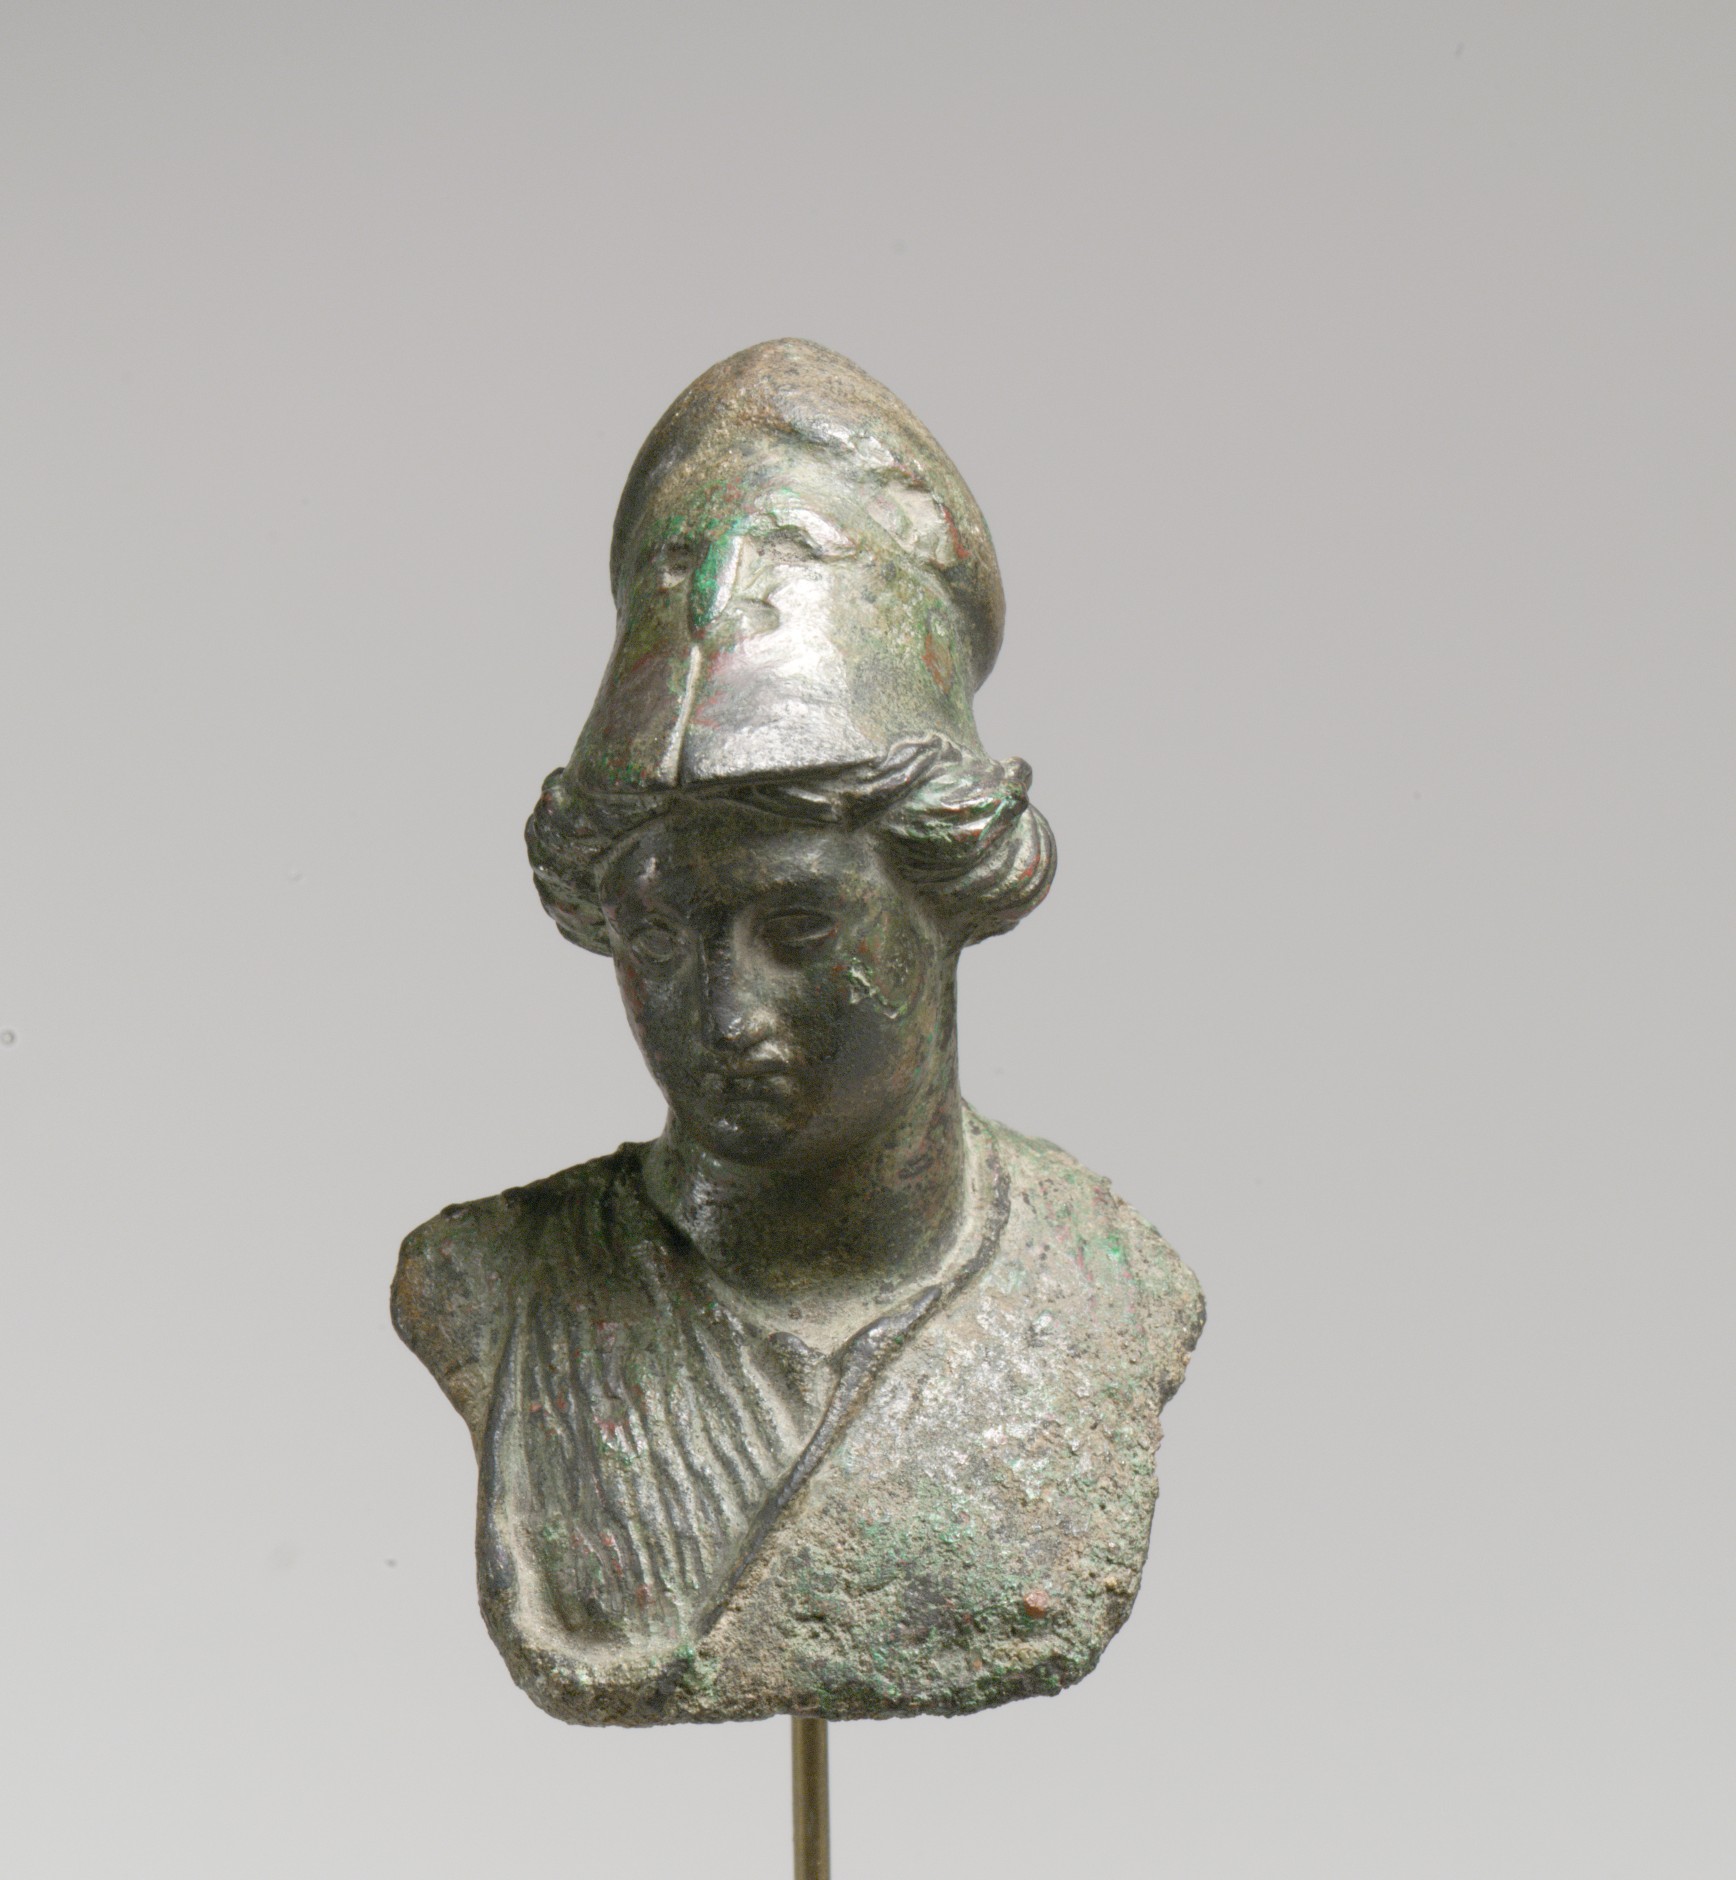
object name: portrait bust of athena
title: Bronze bust of Minerva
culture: roman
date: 1-200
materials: bronze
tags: helmets,portraits,minerva